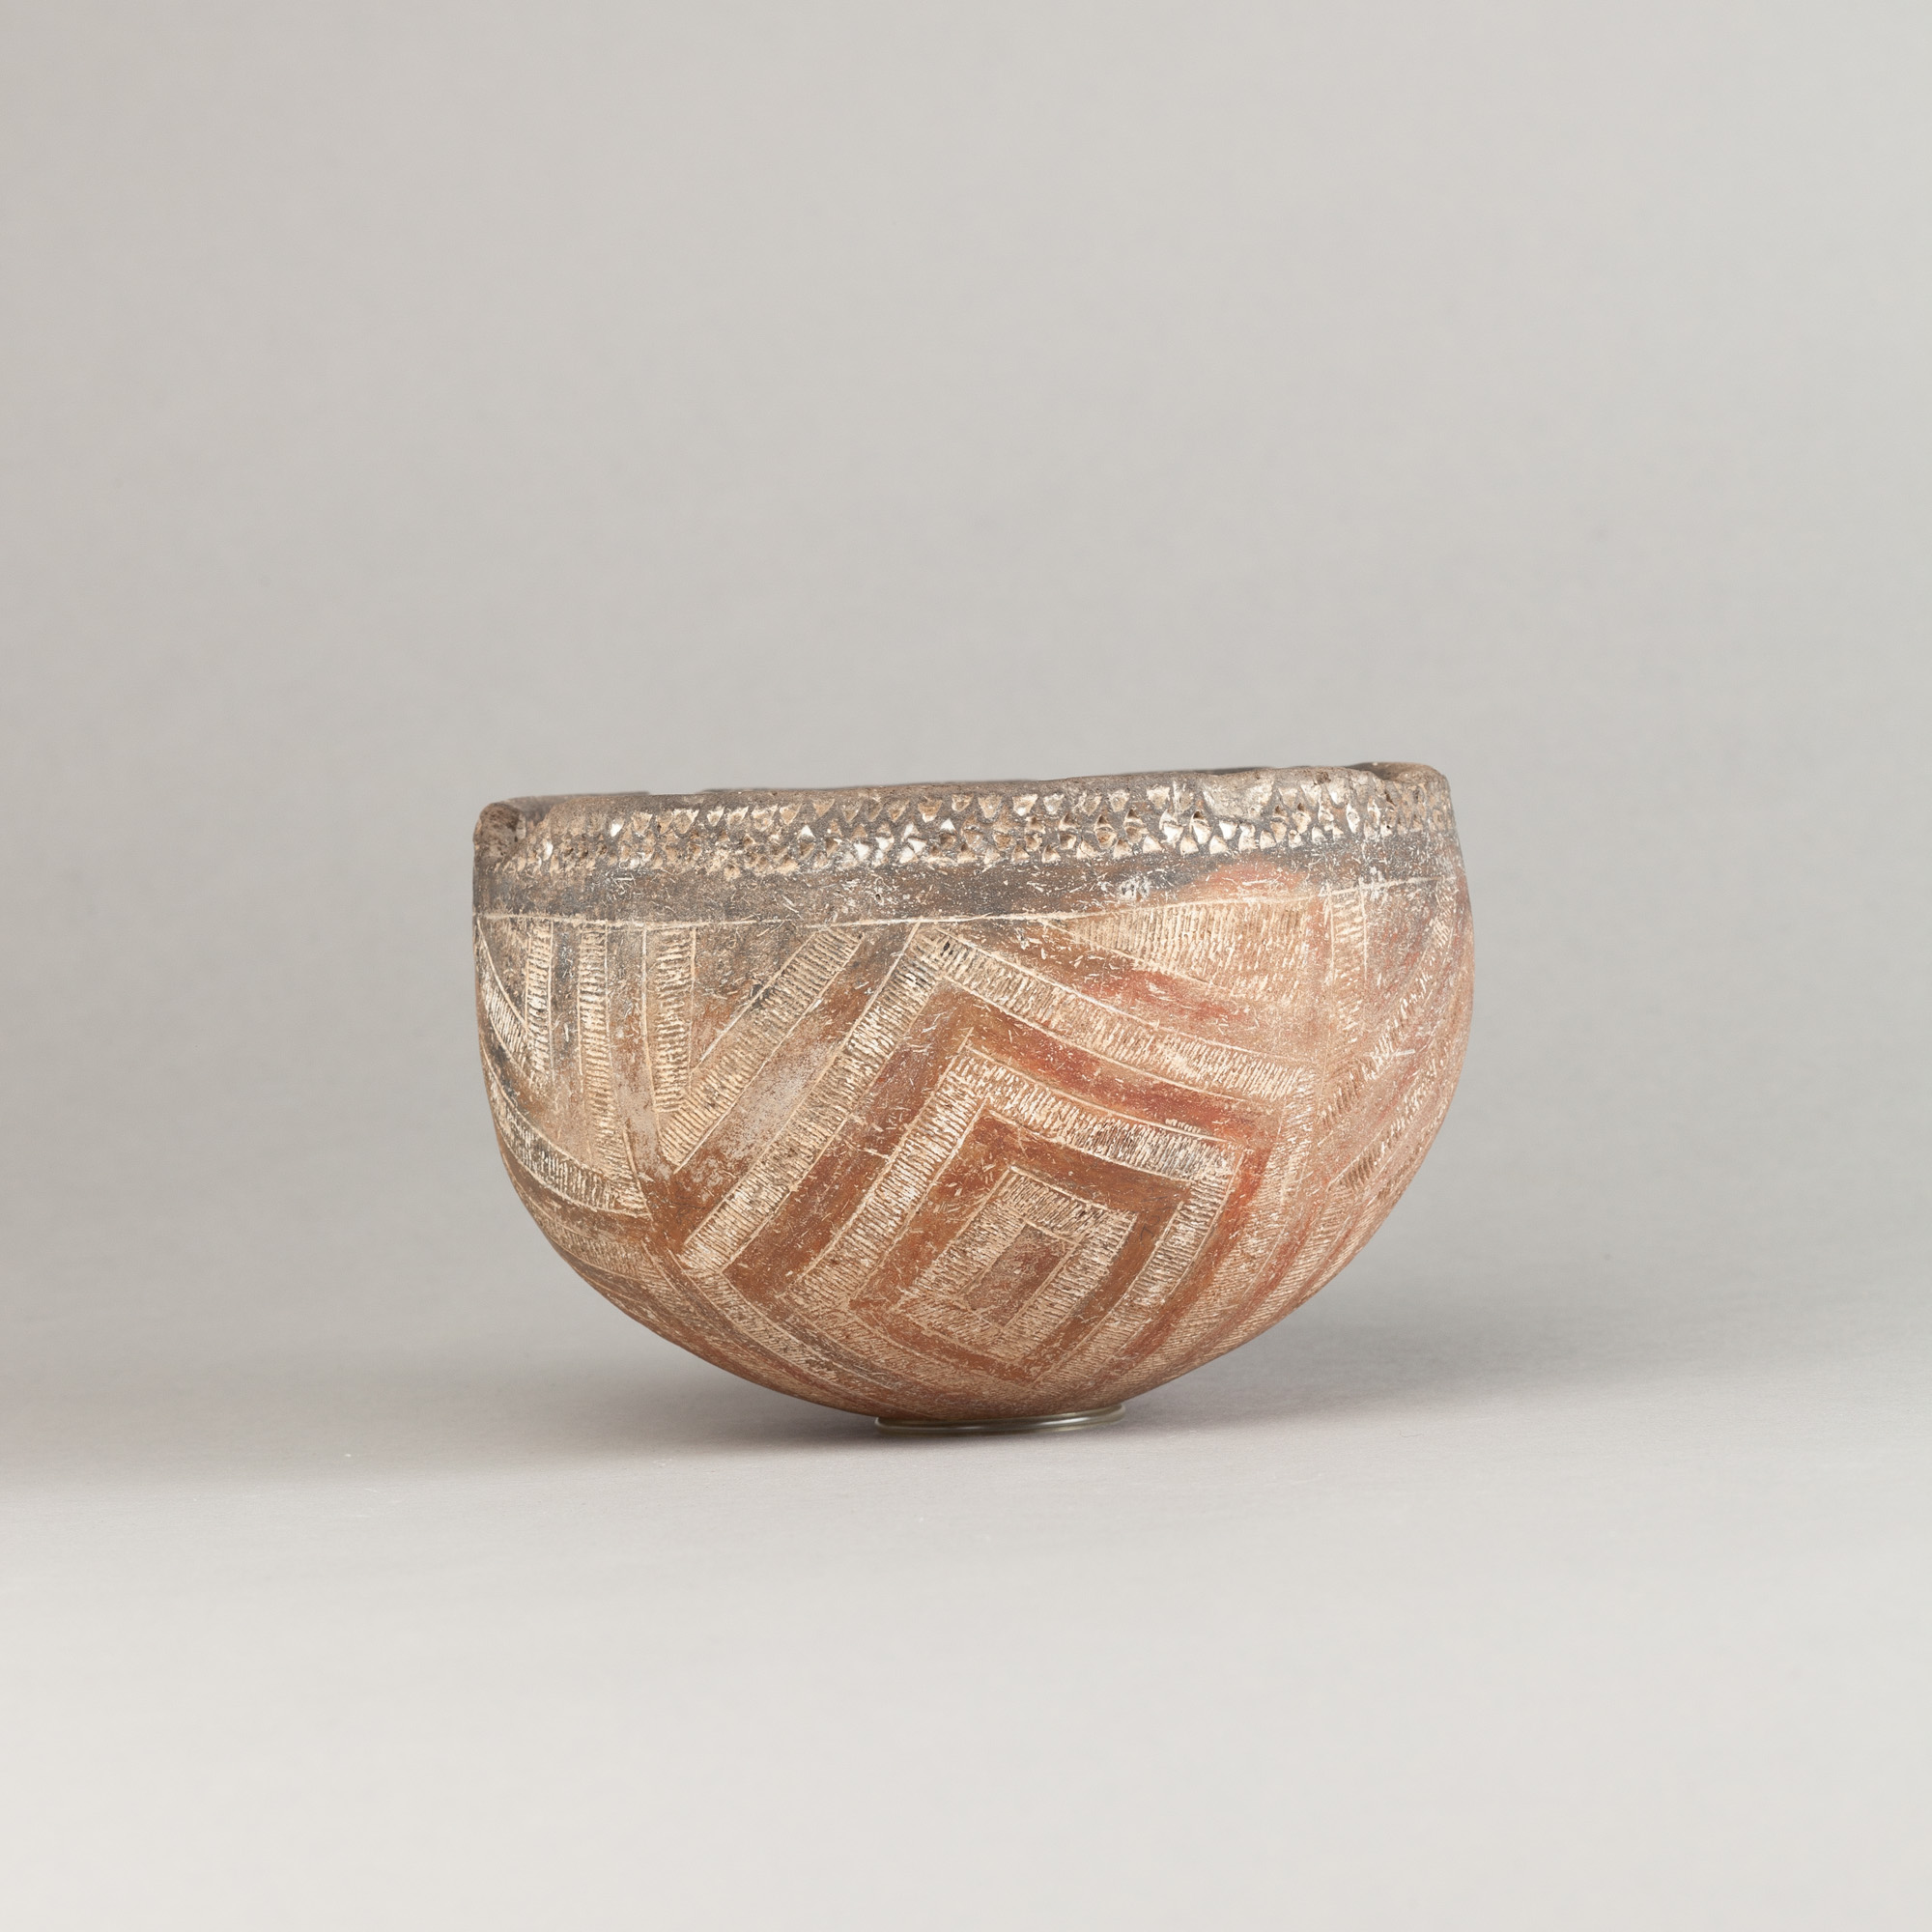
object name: cup, geometric decoration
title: Drinking Cup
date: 1900-1550 BCE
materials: pigment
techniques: polish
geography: nubia